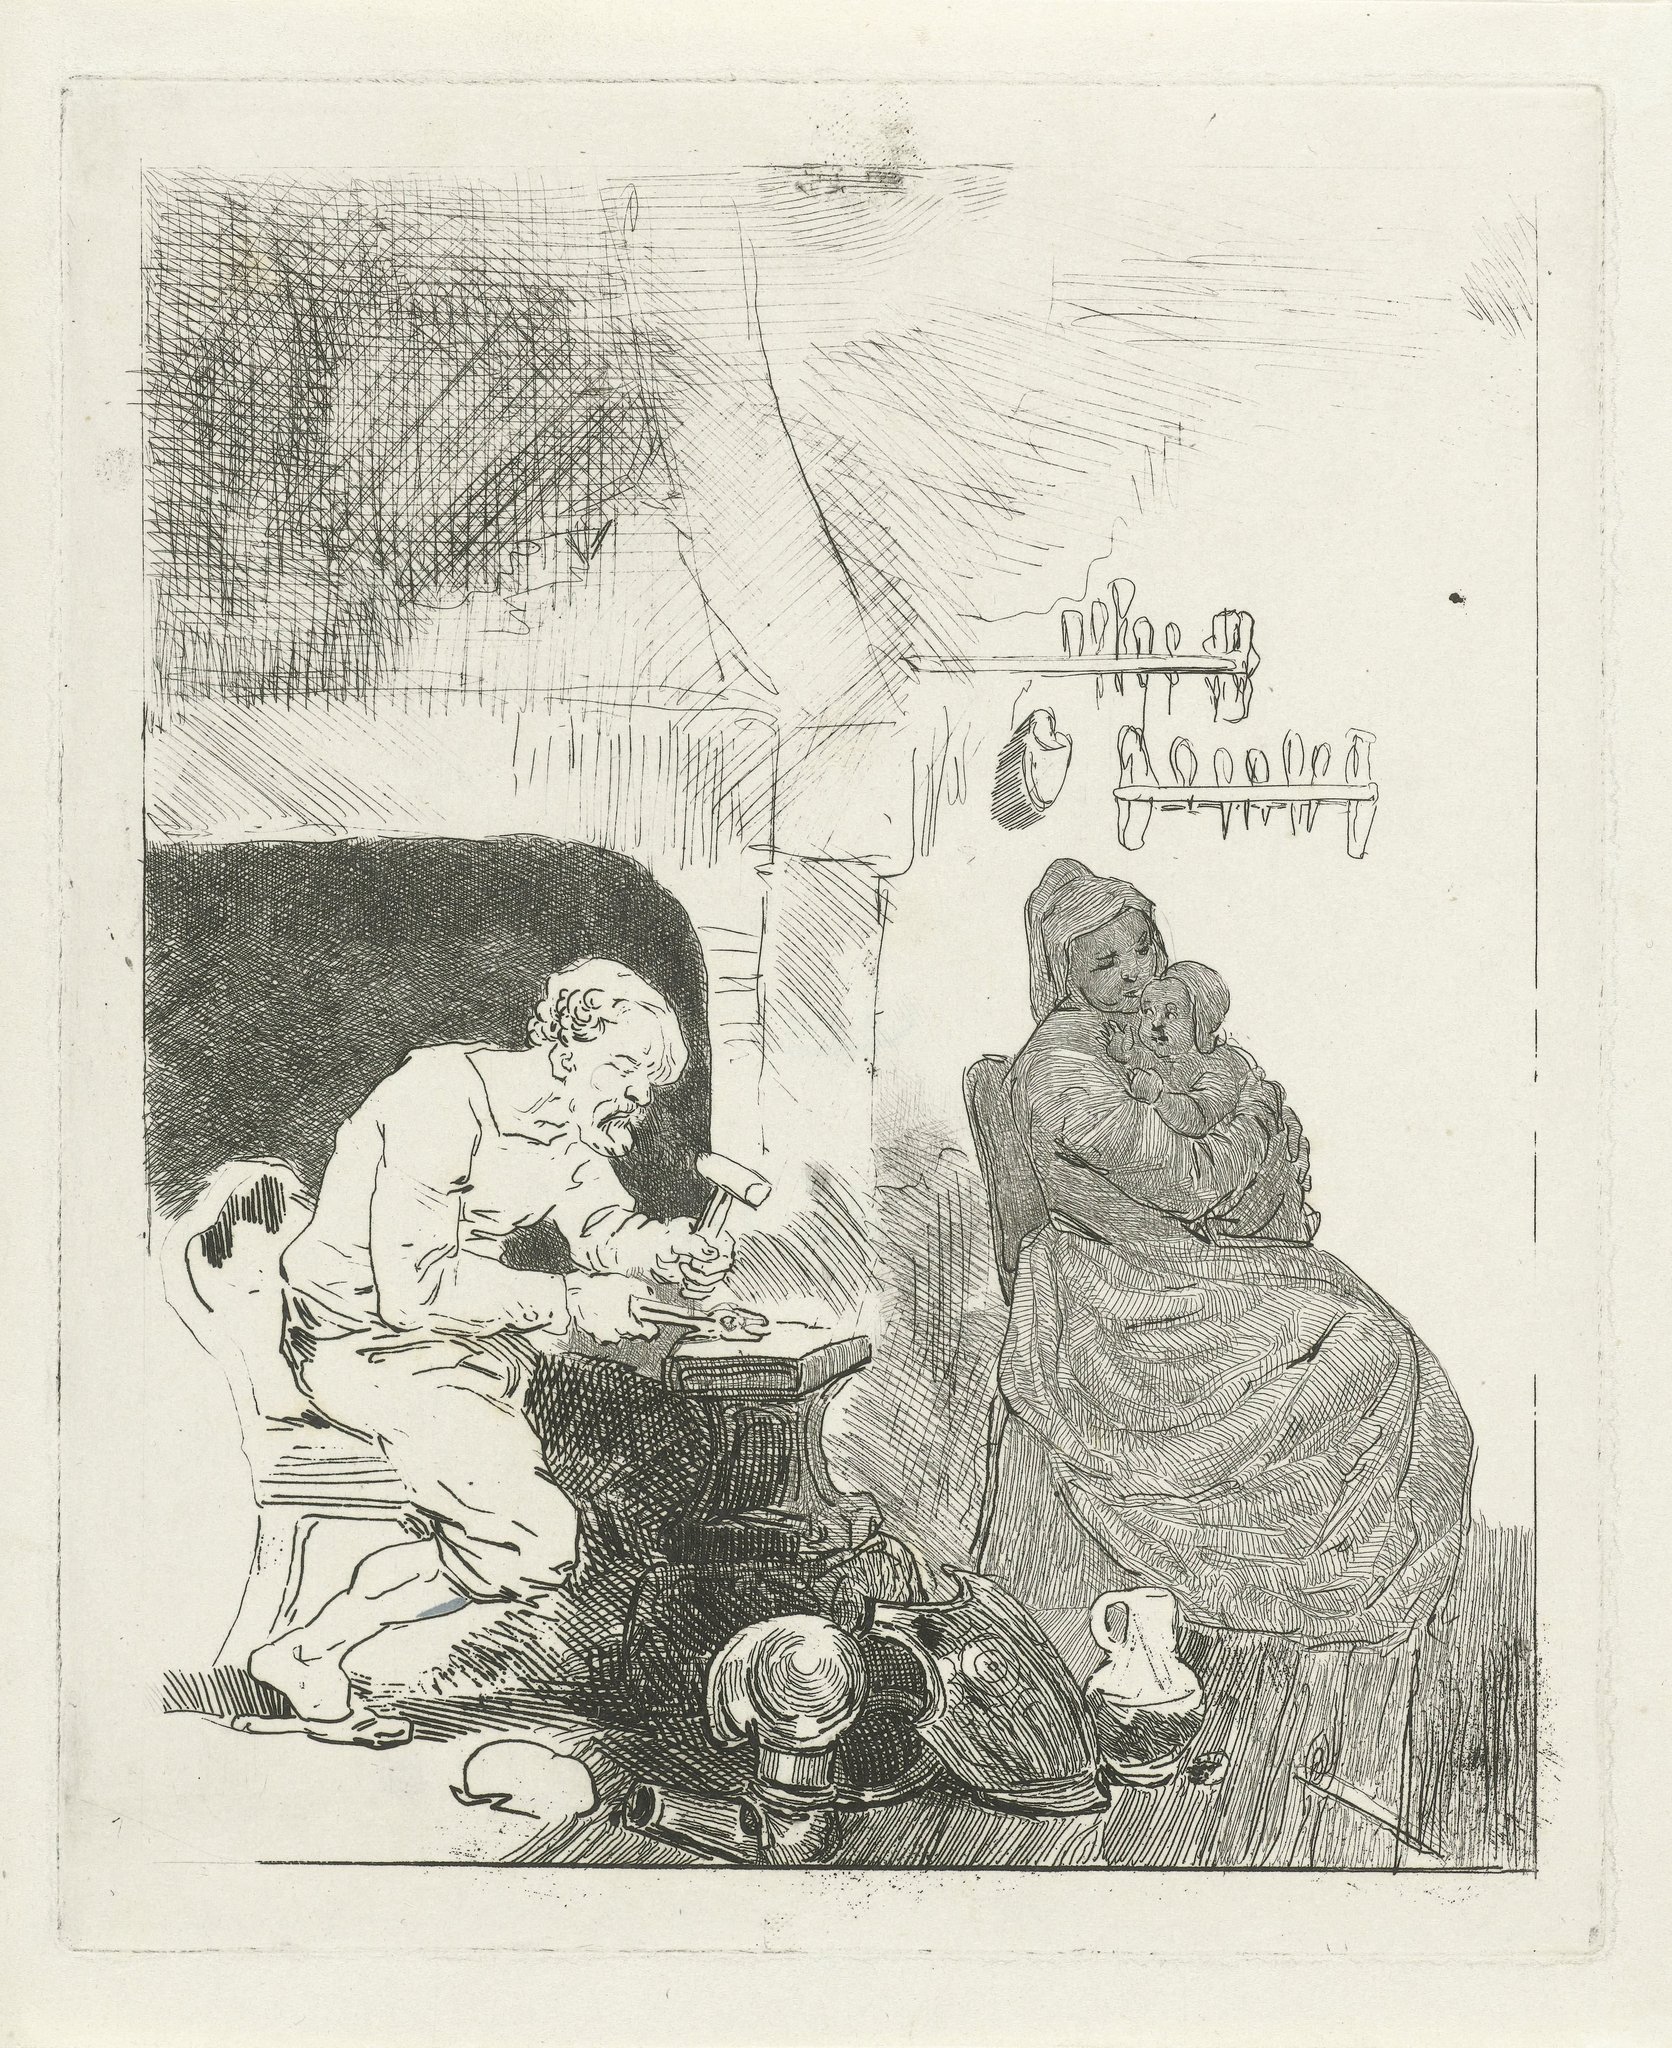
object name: print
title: Wapensmid aan het werk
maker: reinier craeyvanger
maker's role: draughtsman, print maker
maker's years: 1812-1880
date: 1822-1880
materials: paper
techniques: etching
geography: amsterdam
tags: smith, blacksmith (+ indoors; in laboratory, factory, barn, etc.), armour, mother and baby or young child, handicrafts ~ metal, forging (industrial process)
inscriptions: collector's mark: Lugt 2228, collector's mark: Lugt 2760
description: Een wapensmid zit op een stoel voor een aambeeld en bewerkt met een hamer een voorwerp dat hij in een tang vasthoudt. Naast het aambeeld liggen delen van een harnas. Achter hem een haard. Rechts zit zijn vrouw met een kind in de armen.